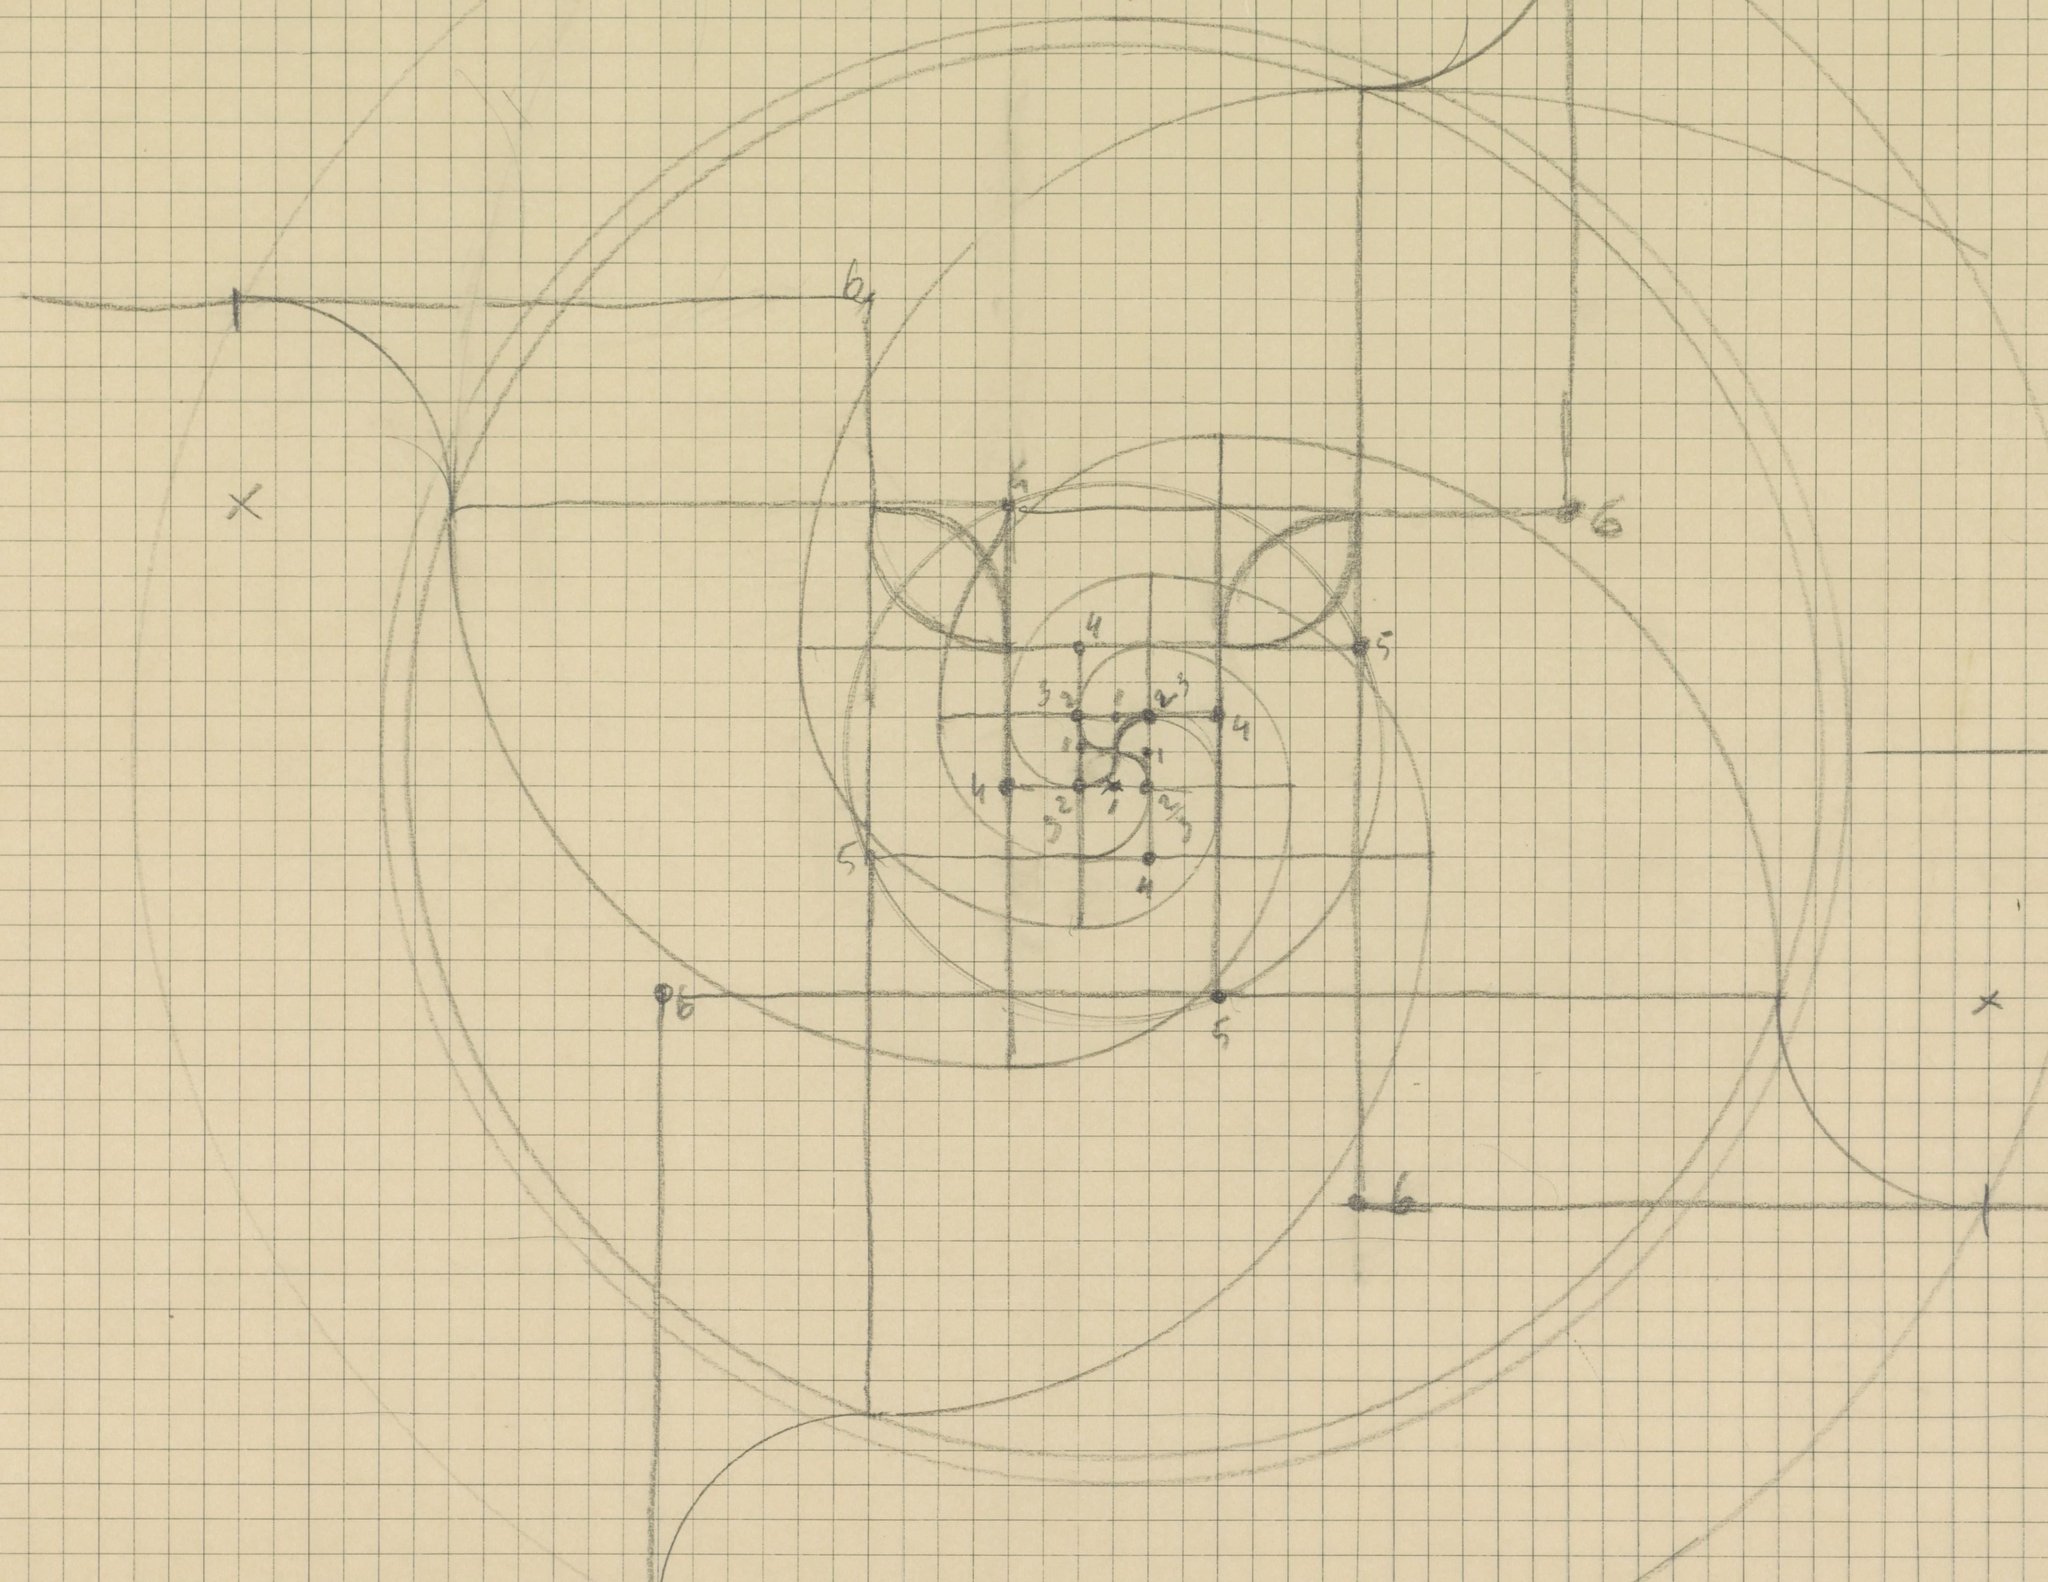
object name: design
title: Ontwerp voor een zilveren fruitschaal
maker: mathieu lauweriks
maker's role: designer, draughtsman, print maker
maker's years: 1864-1932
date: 1874-1932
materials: pencil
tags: dish, plate, saucer, work of applied art (+ precious metals ~ arts)